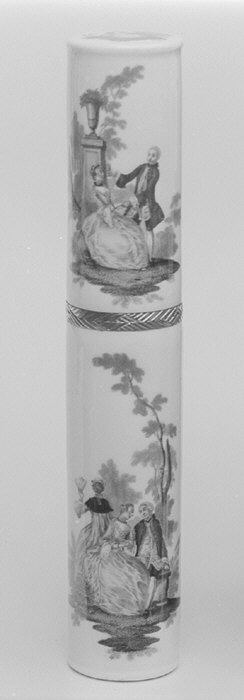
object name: étui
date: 1760-1770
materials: gold, hard paste porcelain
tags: couples,men,women